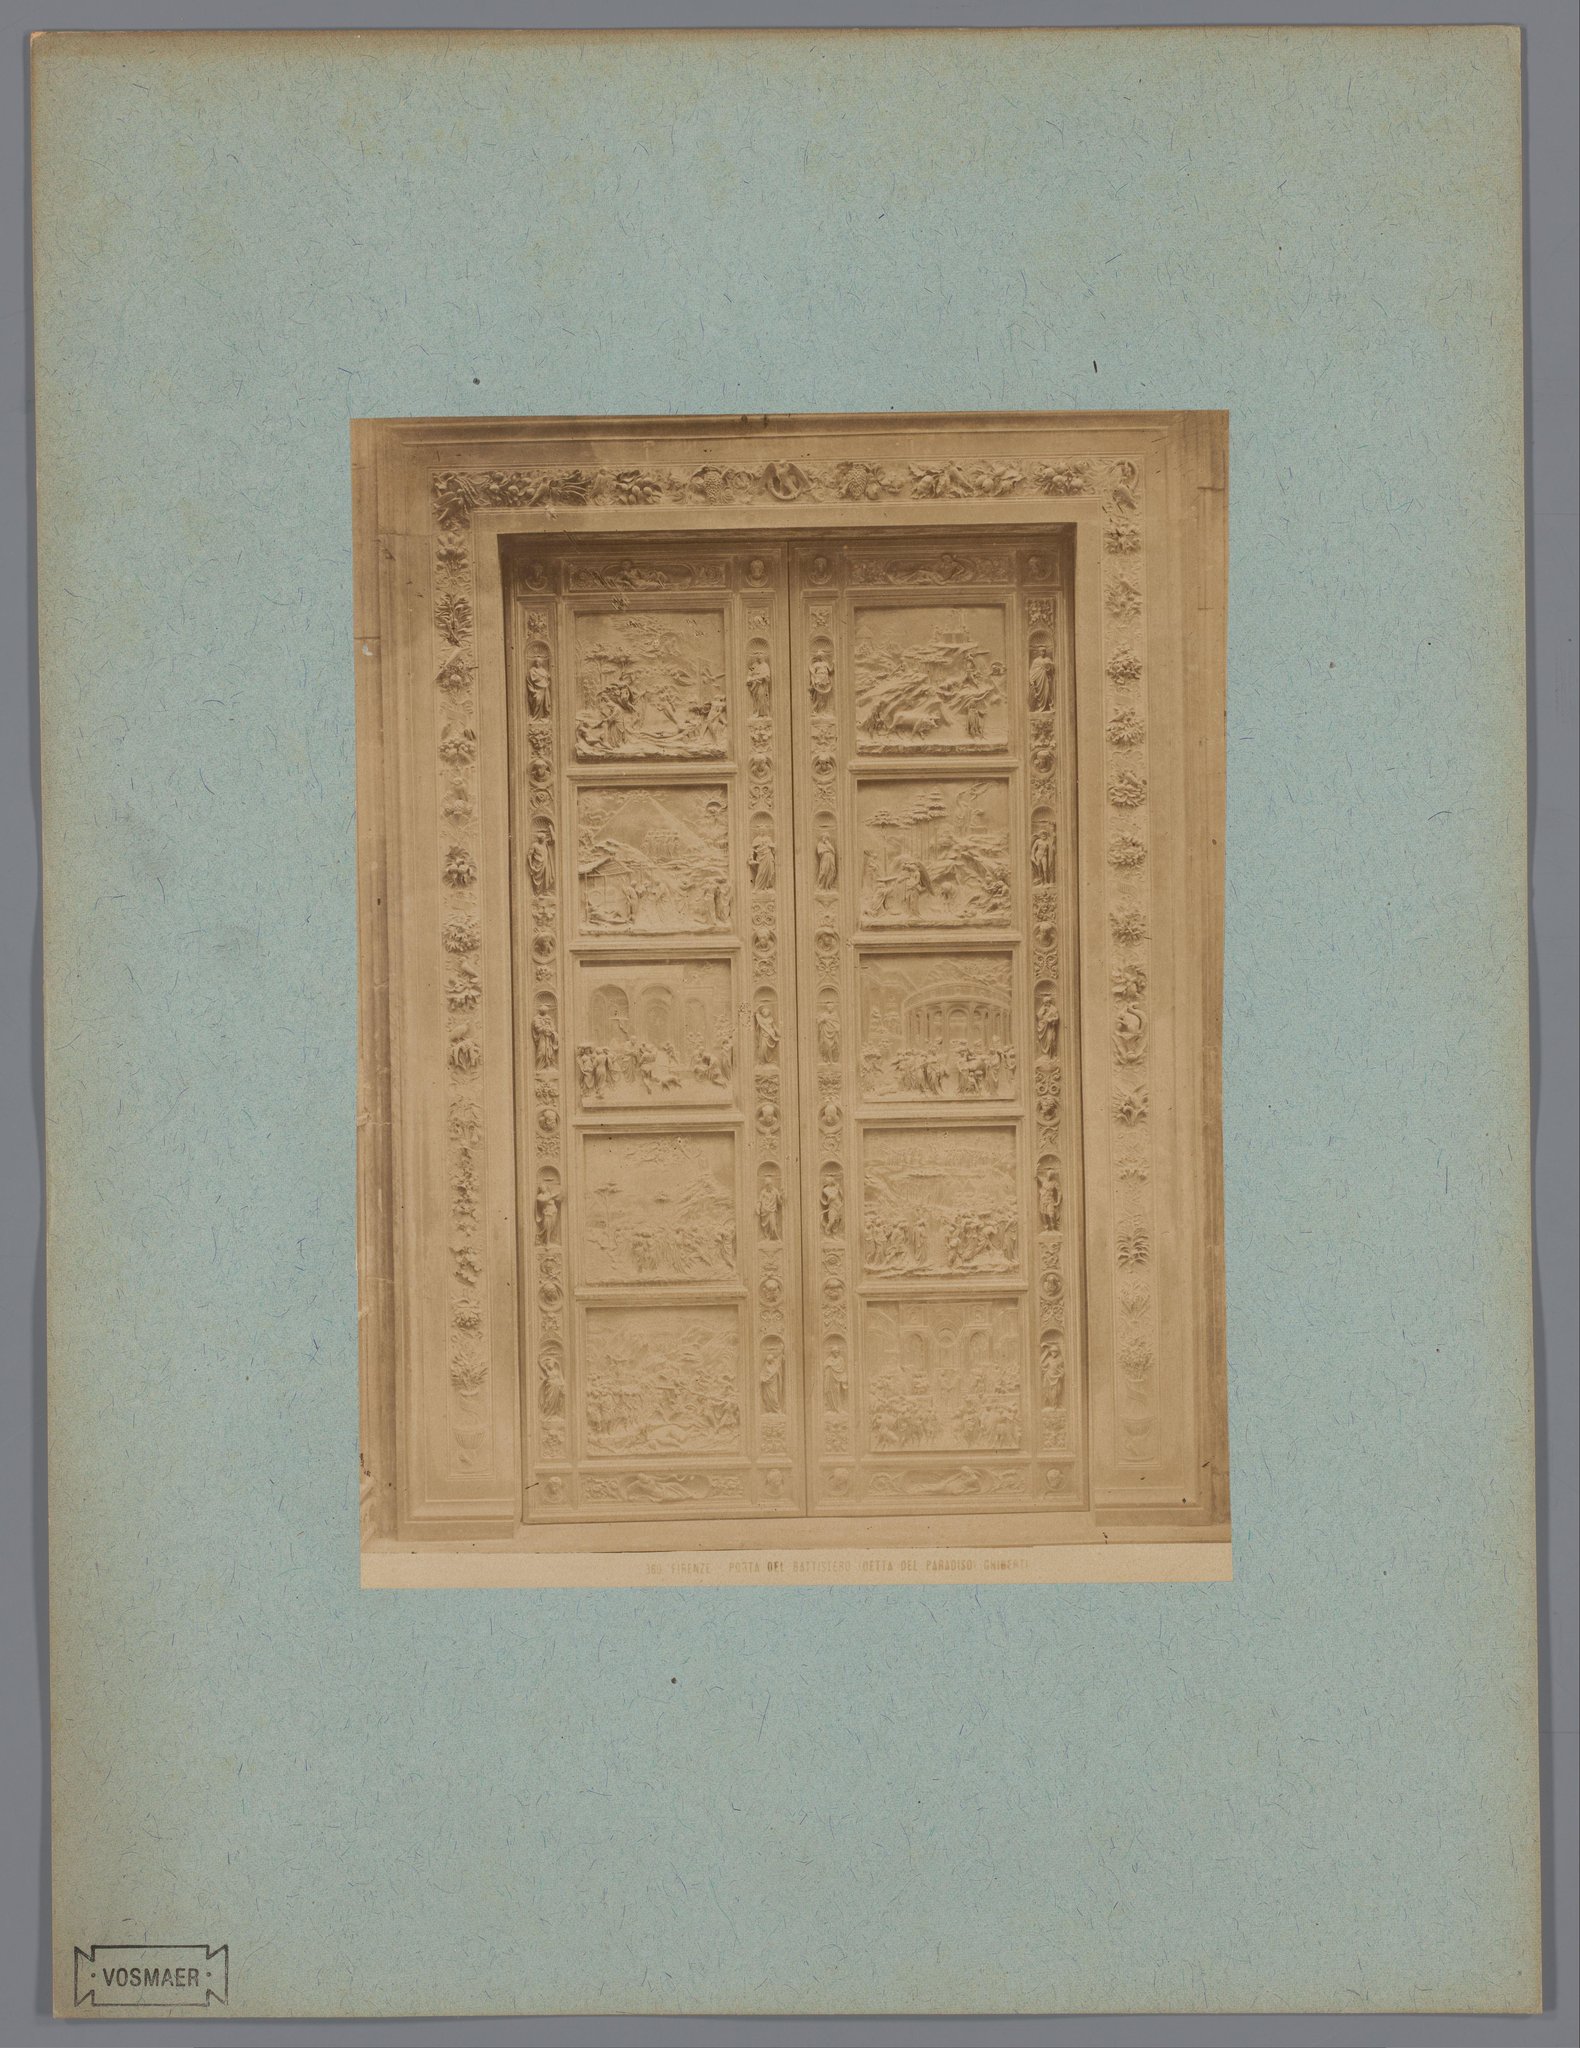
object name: photograph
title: Porta del Battistero detta del Paradiso Ghiberti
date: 1851-1900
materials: cardboard, paper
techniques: albumen print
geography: florence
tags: university building, college, zoology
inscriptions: collector's mark: ‘VOSMAER’, number: ‘360’